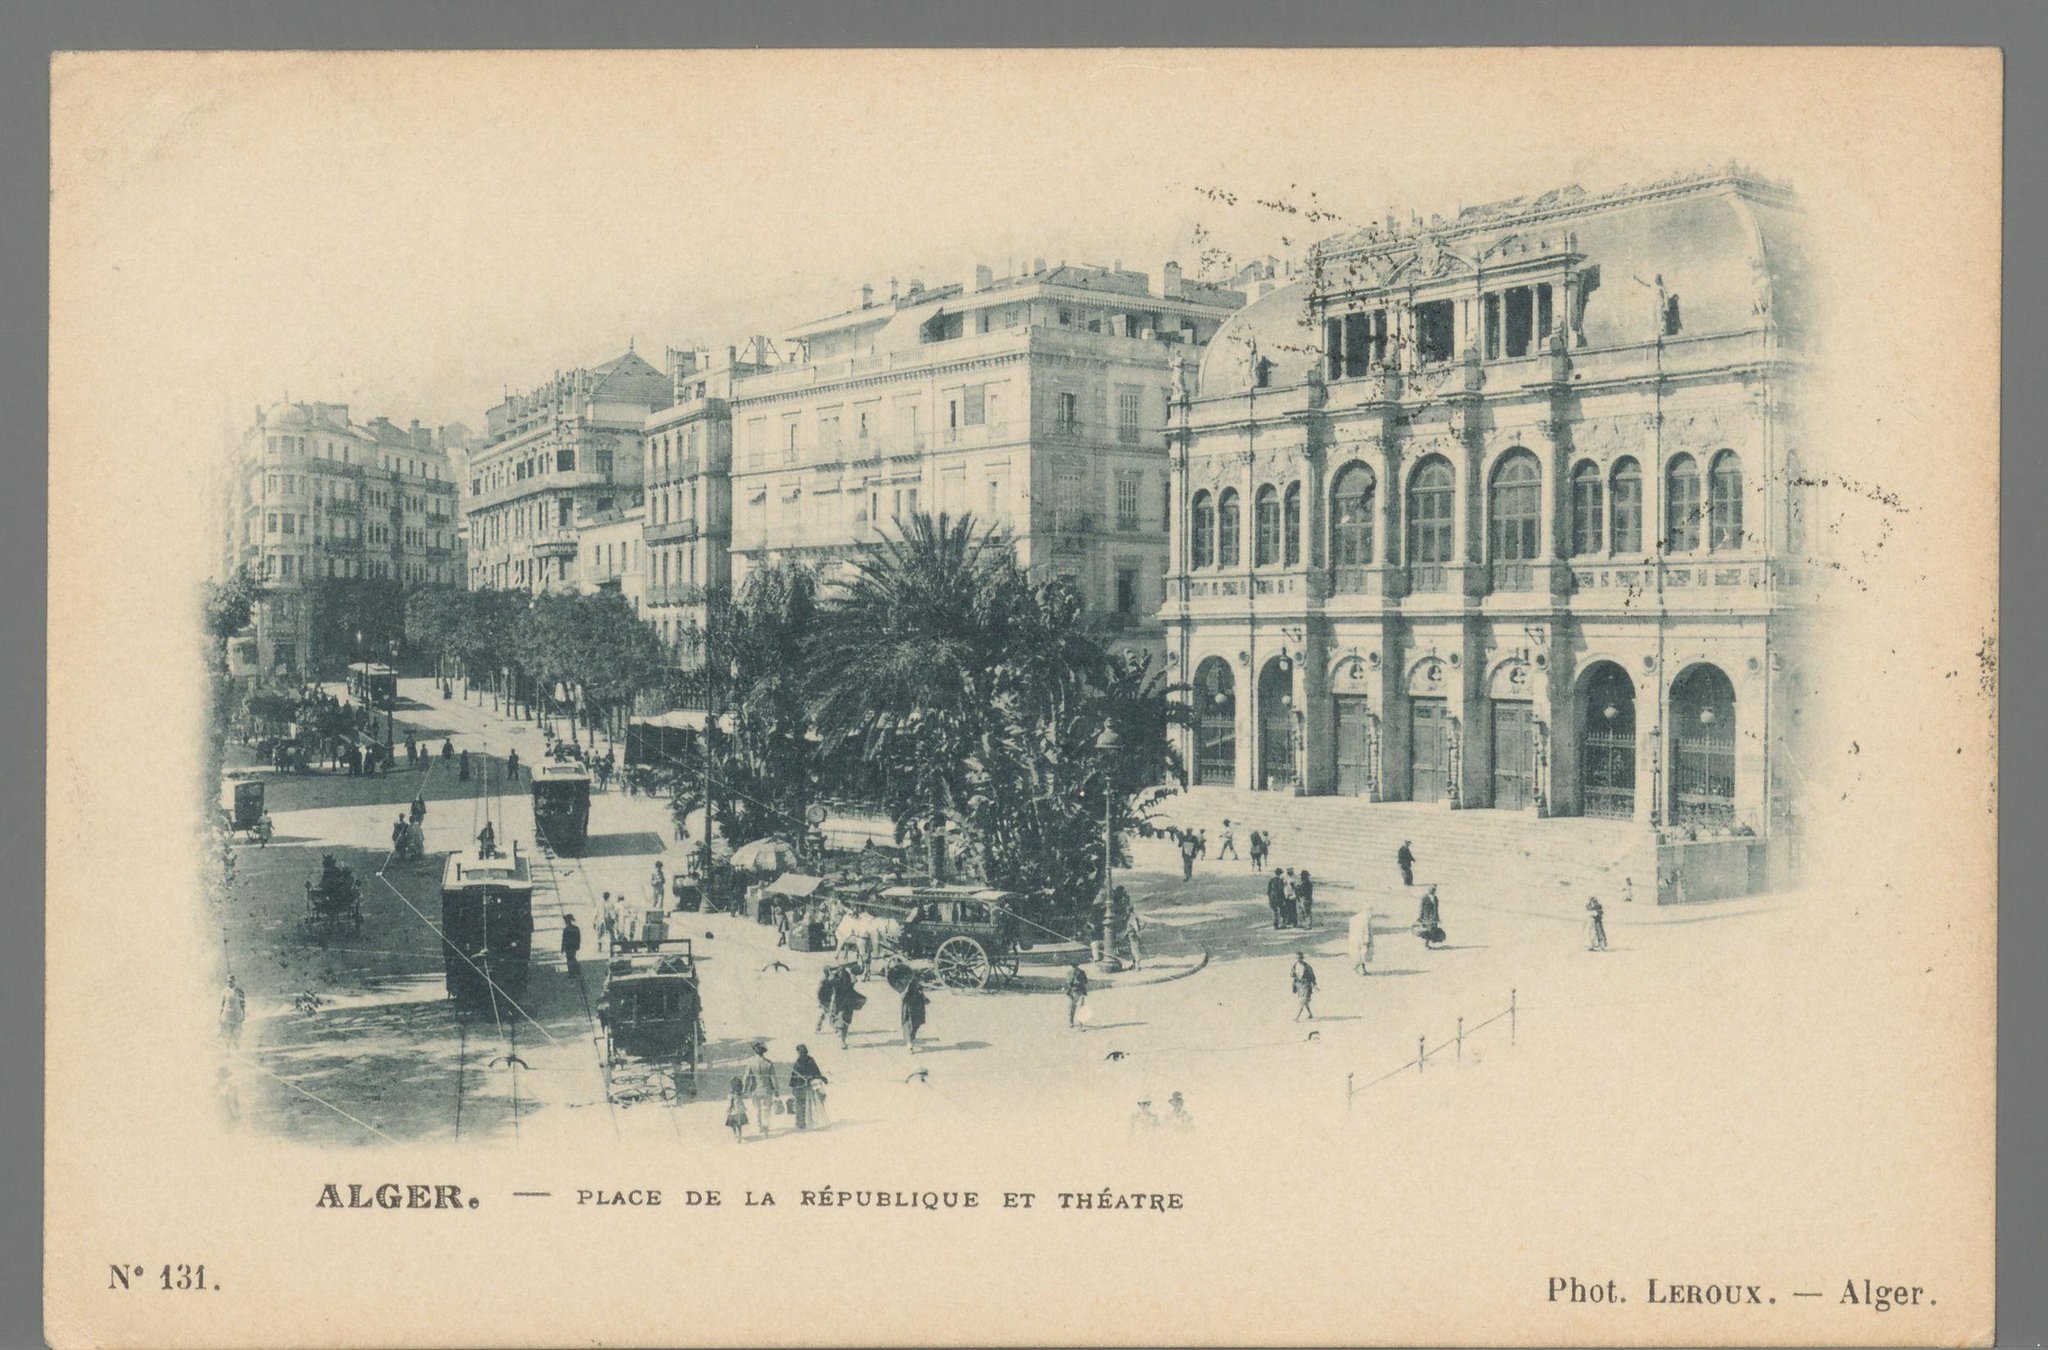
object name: photomechanical print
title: Alger. Place de la République et théatre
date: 1895-1903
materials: cardboard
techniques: photograph, writing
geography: algiers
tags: tram, theatre (building), square, place, circus, etc. (+ city(-scape) with figures, staffage)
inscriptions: postage stamp